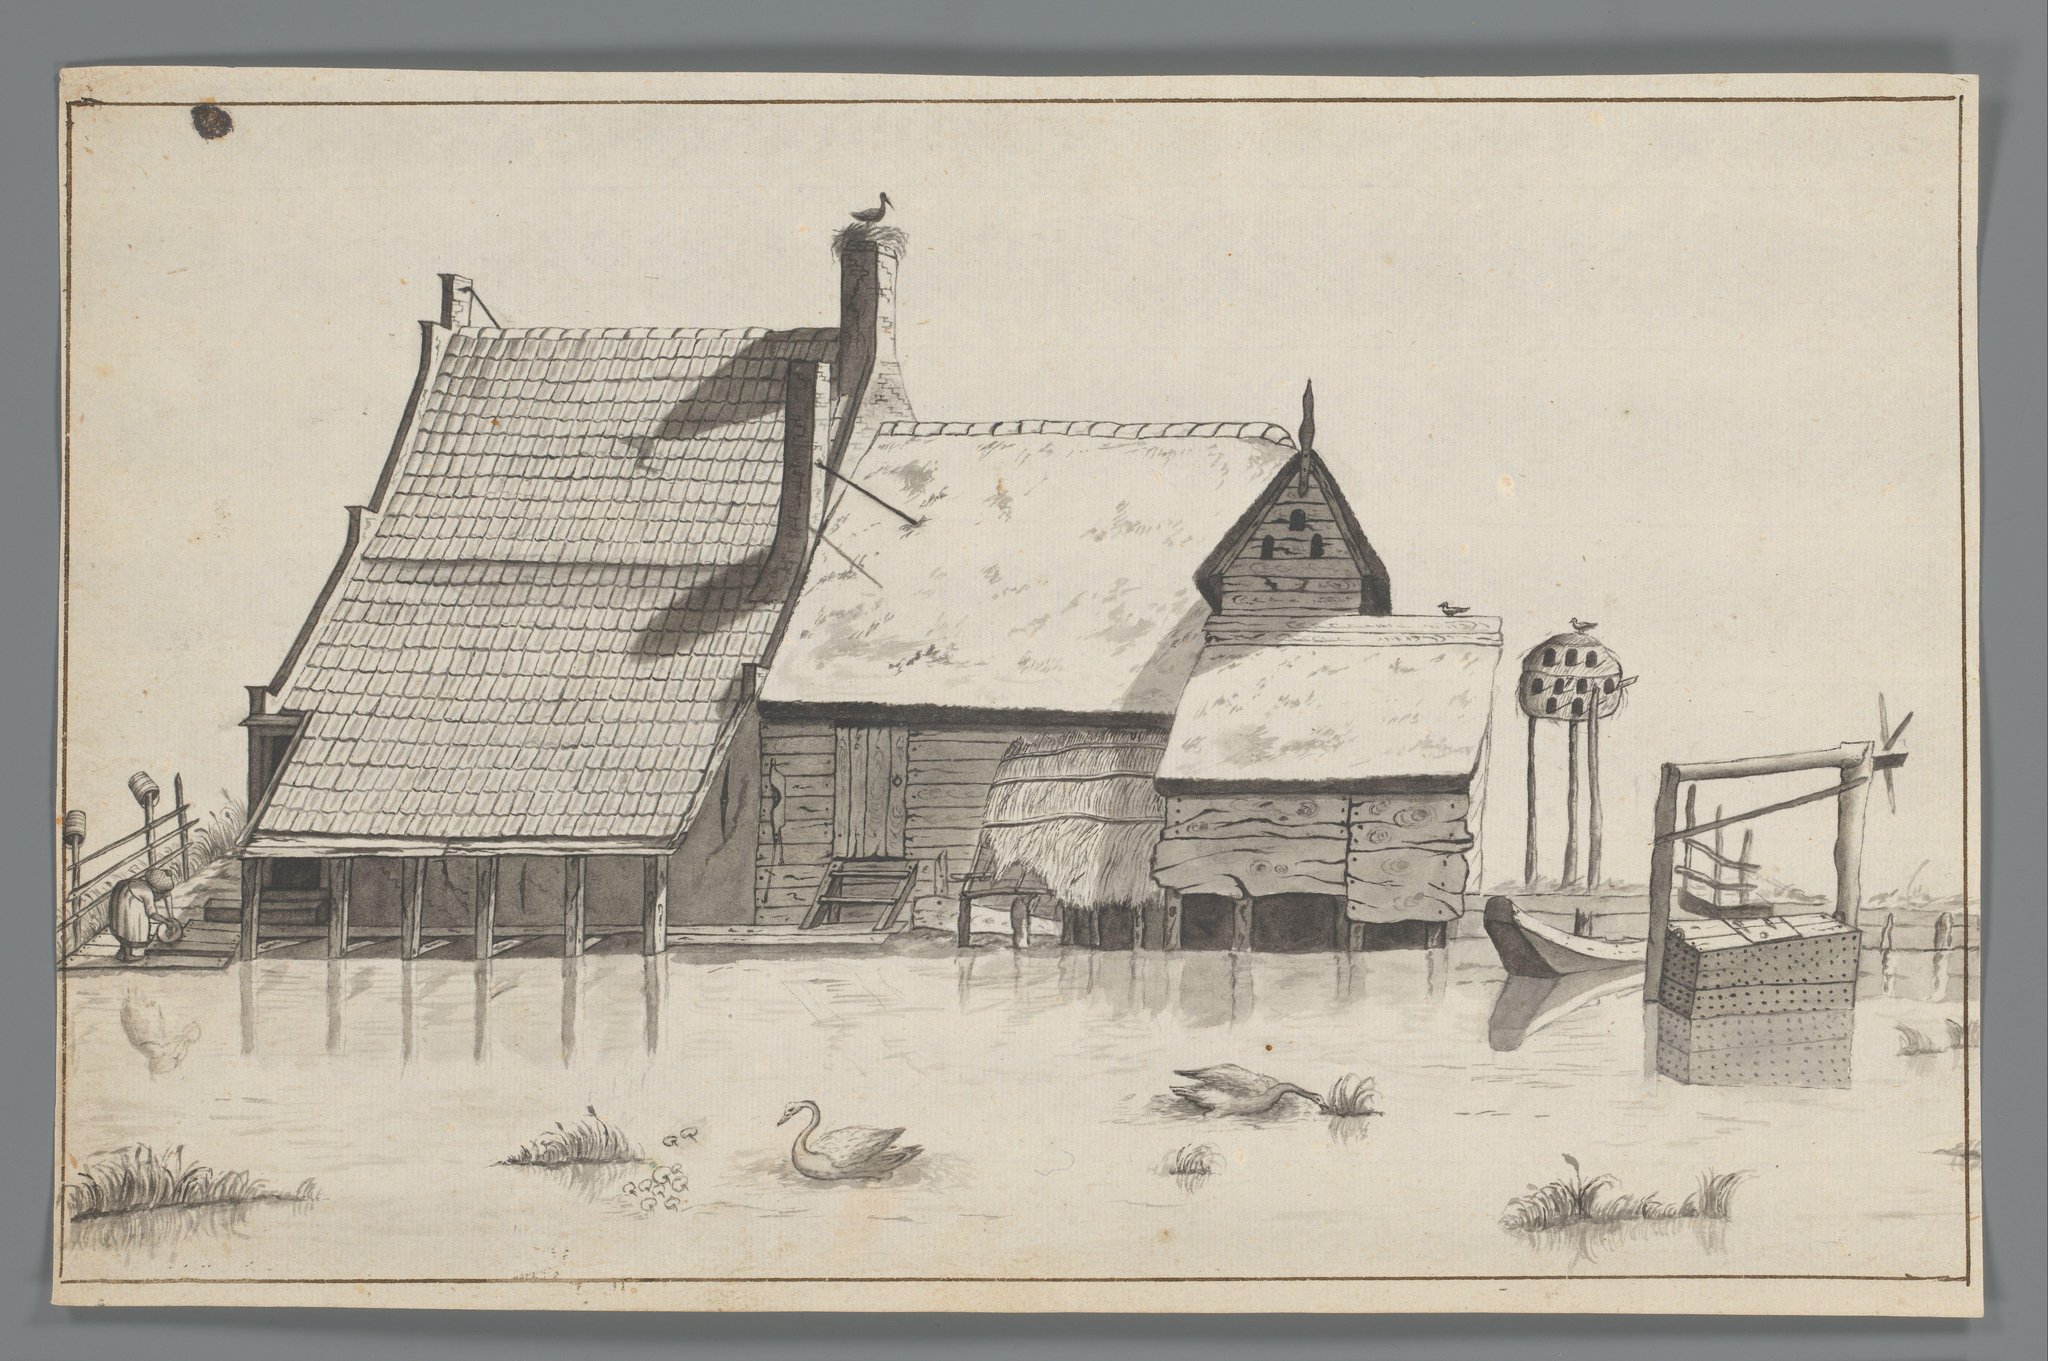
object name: drawing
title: Boerderij aan het water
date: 1700-1799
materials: paper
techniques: brush, pen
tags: water-birds: swan, dove-cote, farm (building)